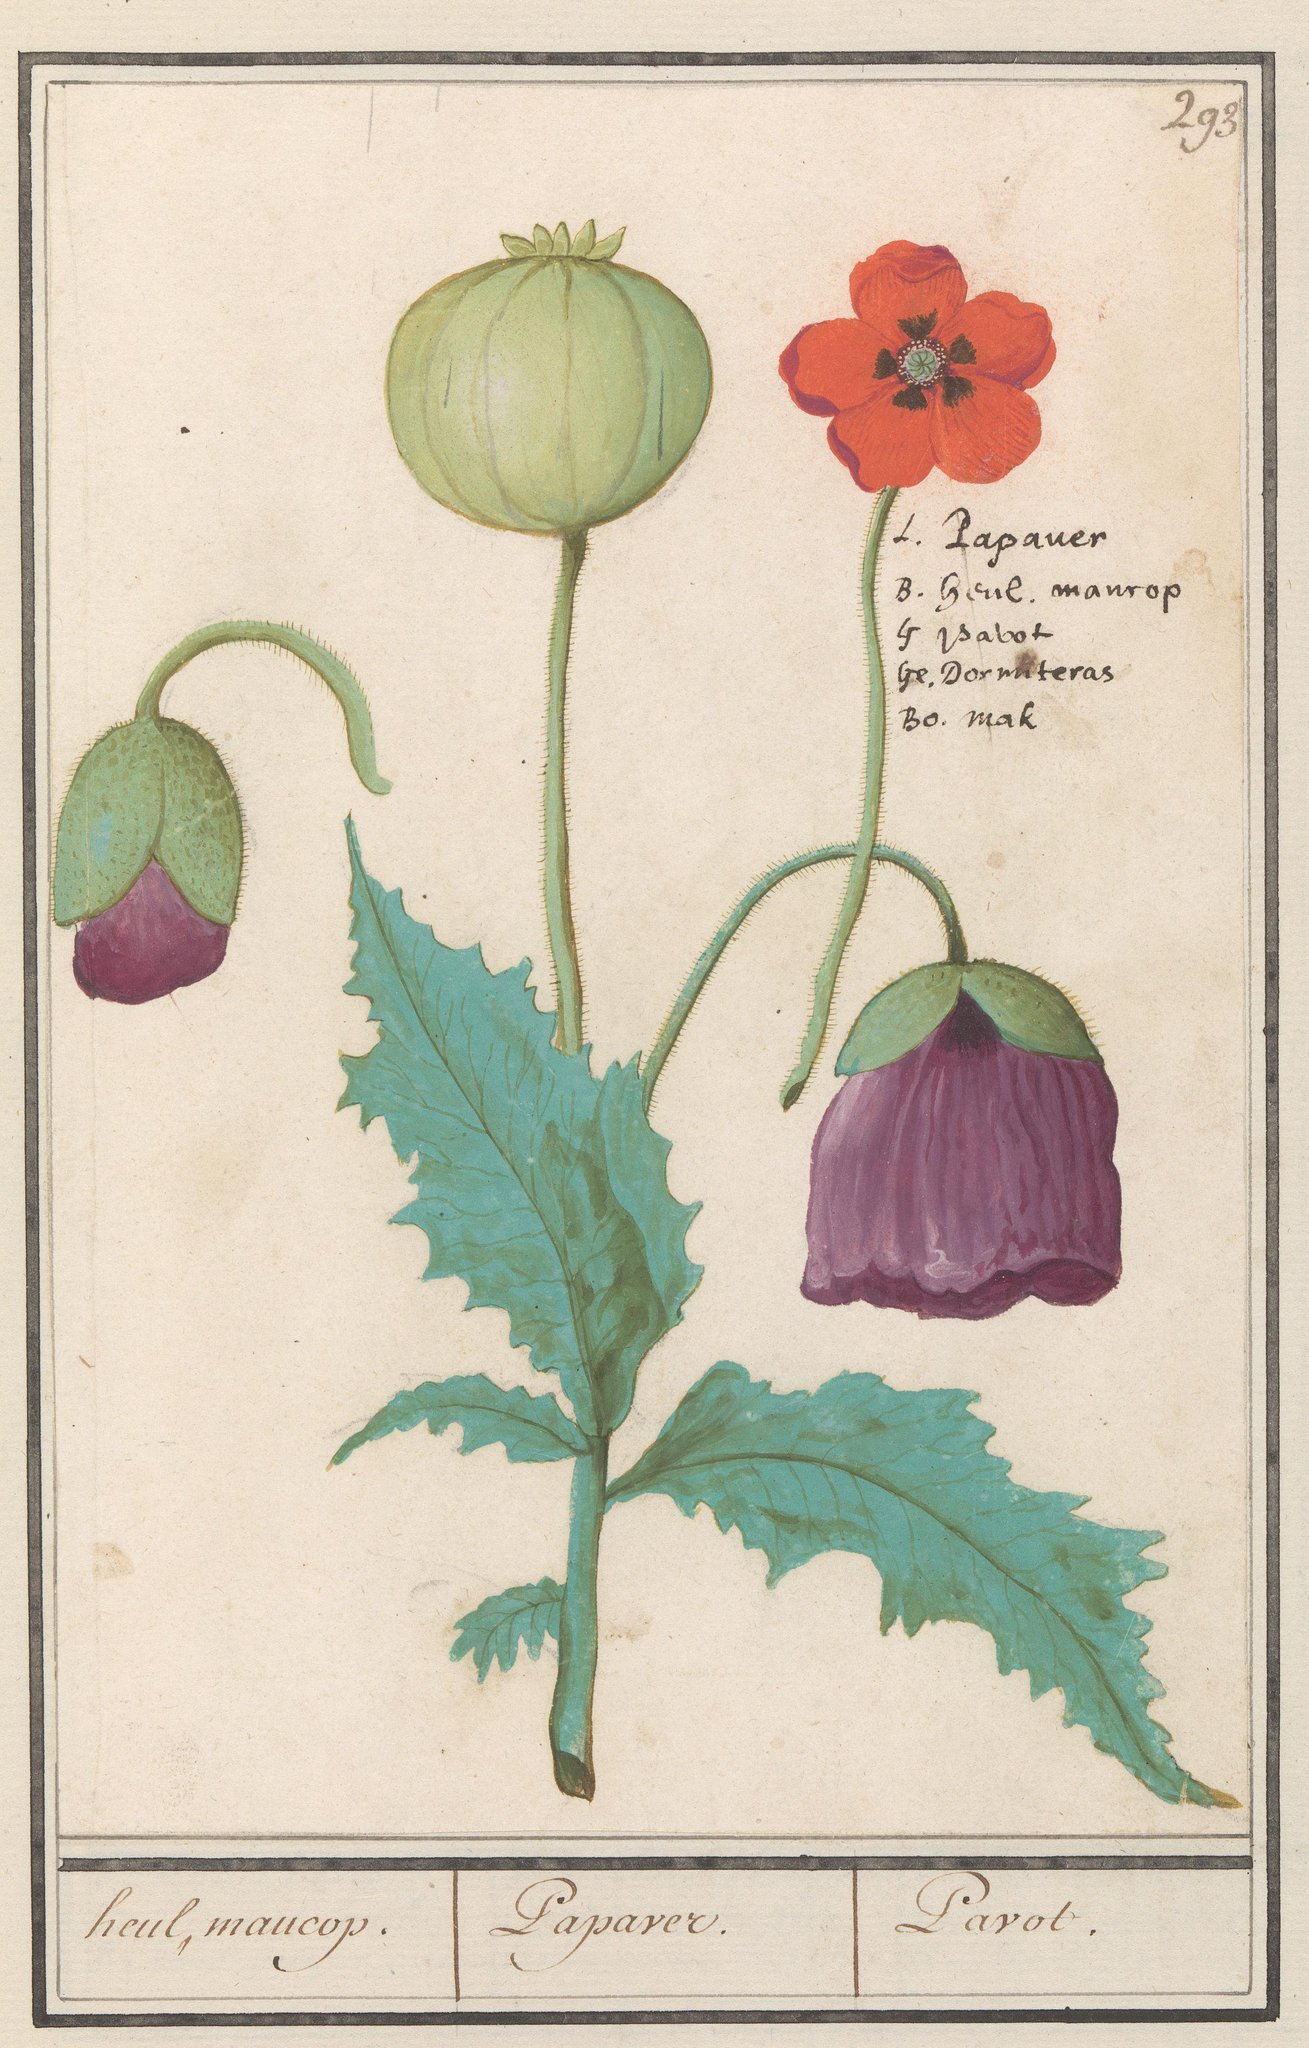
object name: drawing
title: Papaver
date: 1596-1610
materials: chalk, paint, ink, paper, watercolor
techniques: brush, pen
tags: flowers: poppy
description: Klaproos of papaver. Genummerd rechtsboven: 293. Hierbij ook de naam in vijf talen. Onderdeel van het derde album met tekeningen van bloemen en planten. Tiende van twaalf albums met tekeningen van dieren, vogels en planten bekend rond 1600, gemaakt in opdracht van keizer Rudolf II. Met toelichting in Nederlands, Latijn en Frans.